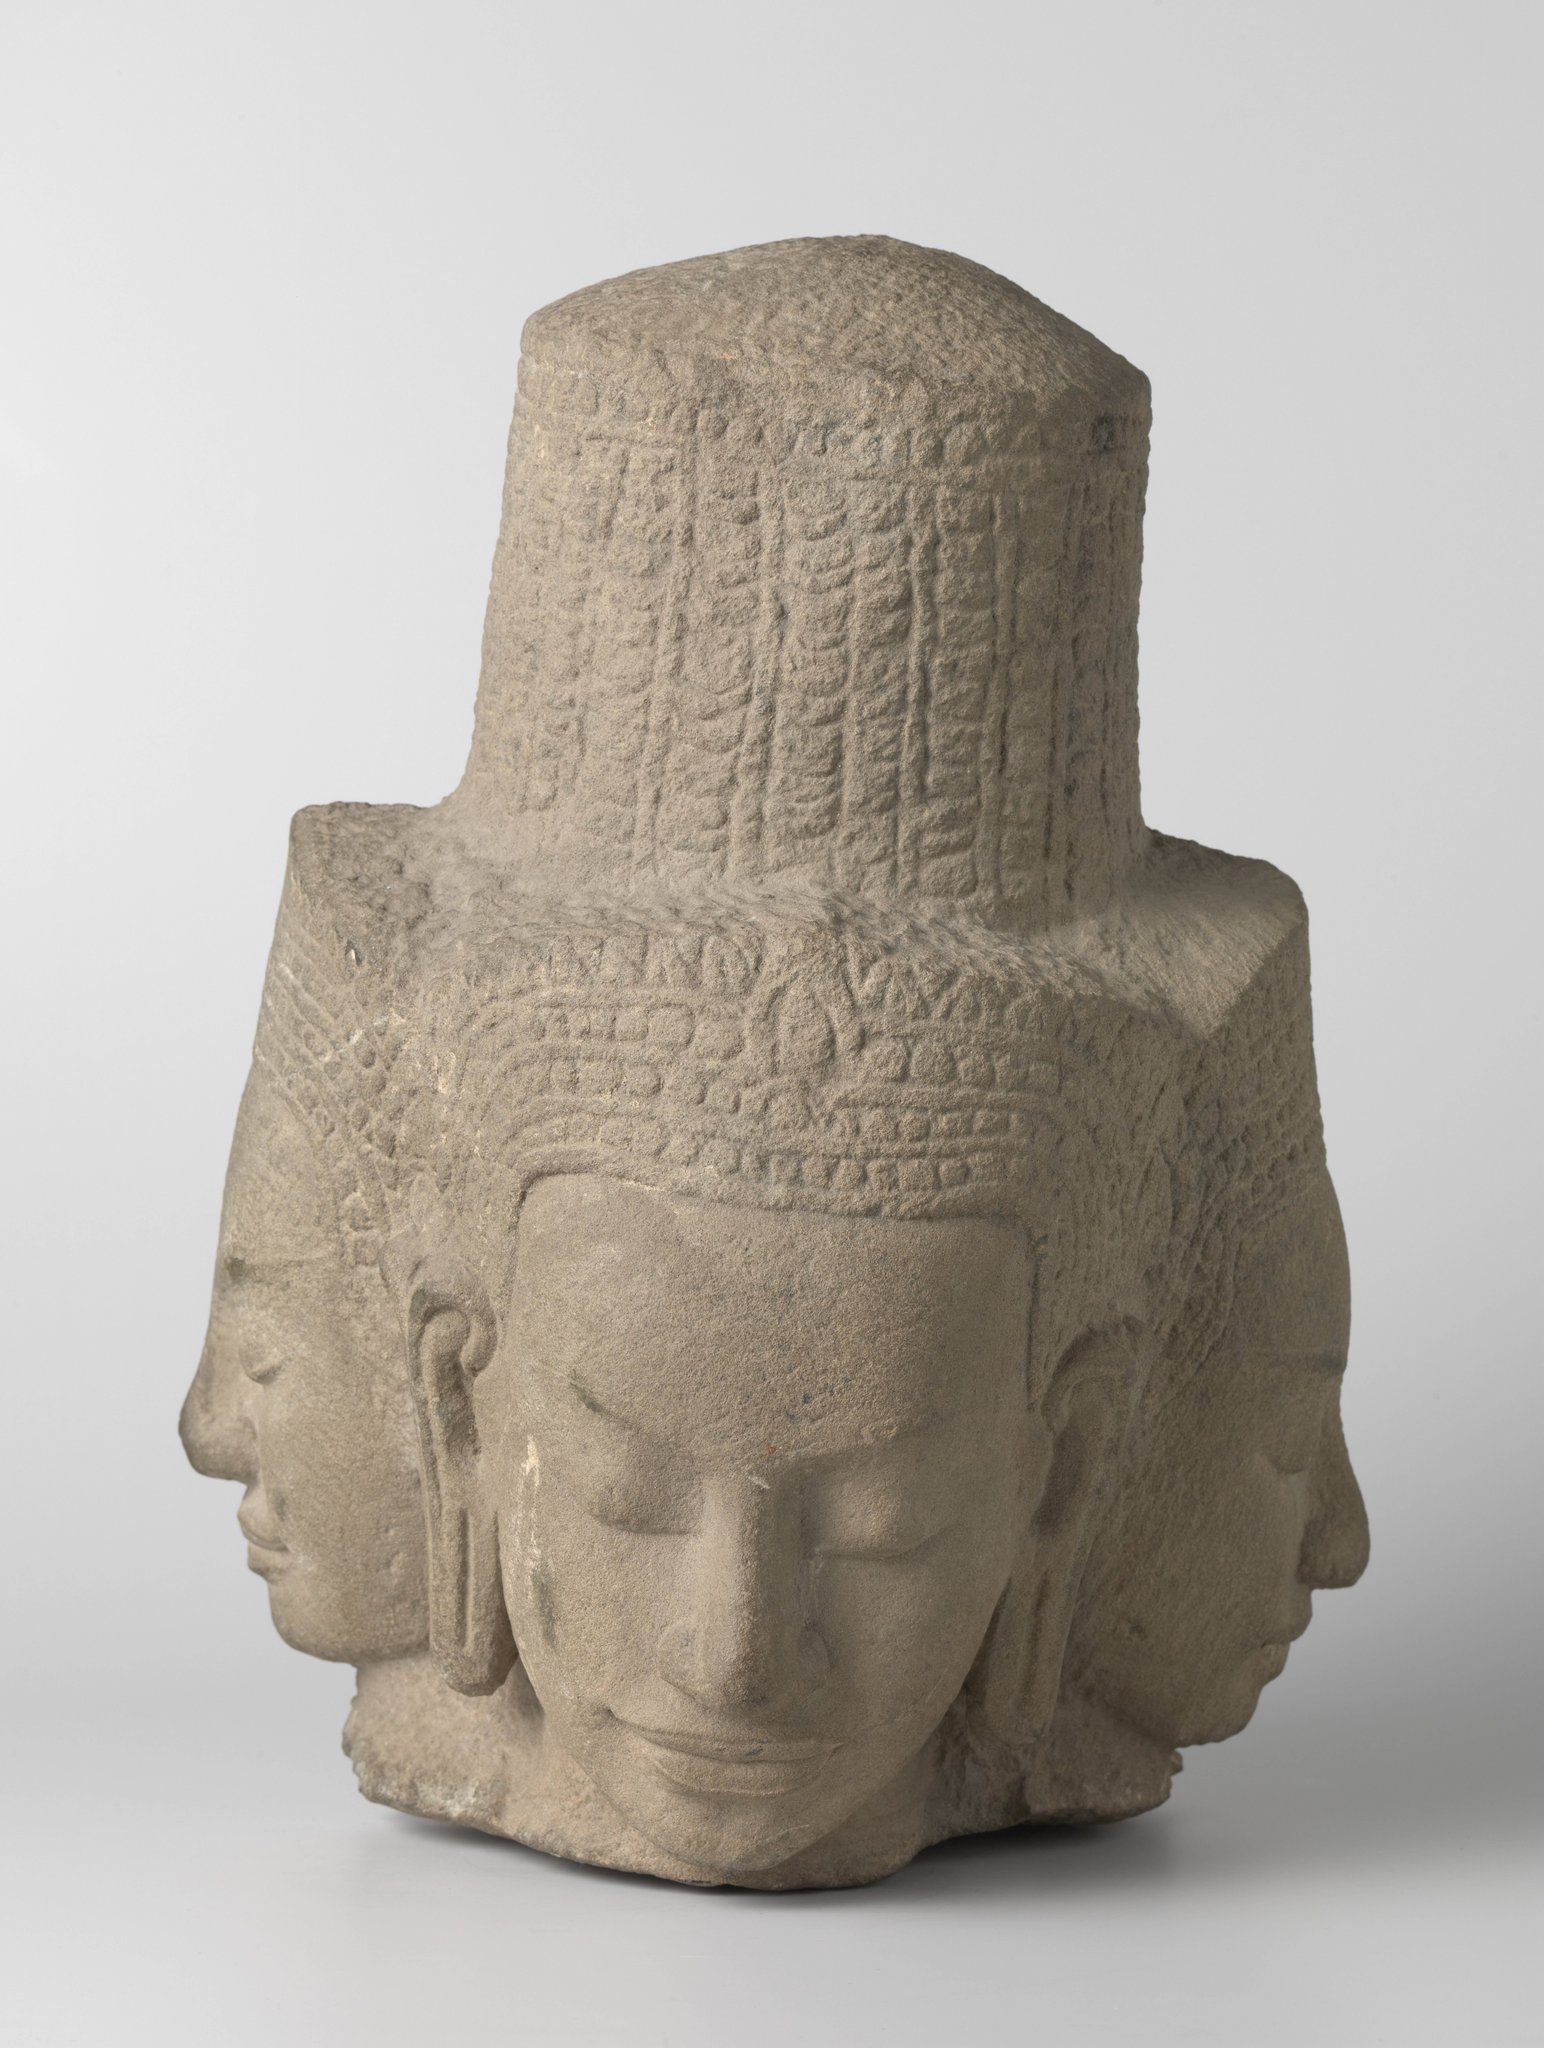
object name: hoofd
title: Head of a deity with four faces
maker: Anonymous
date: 1175-1250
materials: stone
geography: angkor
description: This head, which once had four faces, comes from the large Buddhist temple of Ta Prohm at Angkor. It perhaps represents Prajnaparamita, the Buddhist goddess of wisdom, rather than a male deity or bodhisattva. This is suggested by the female features on the three surviving faces.